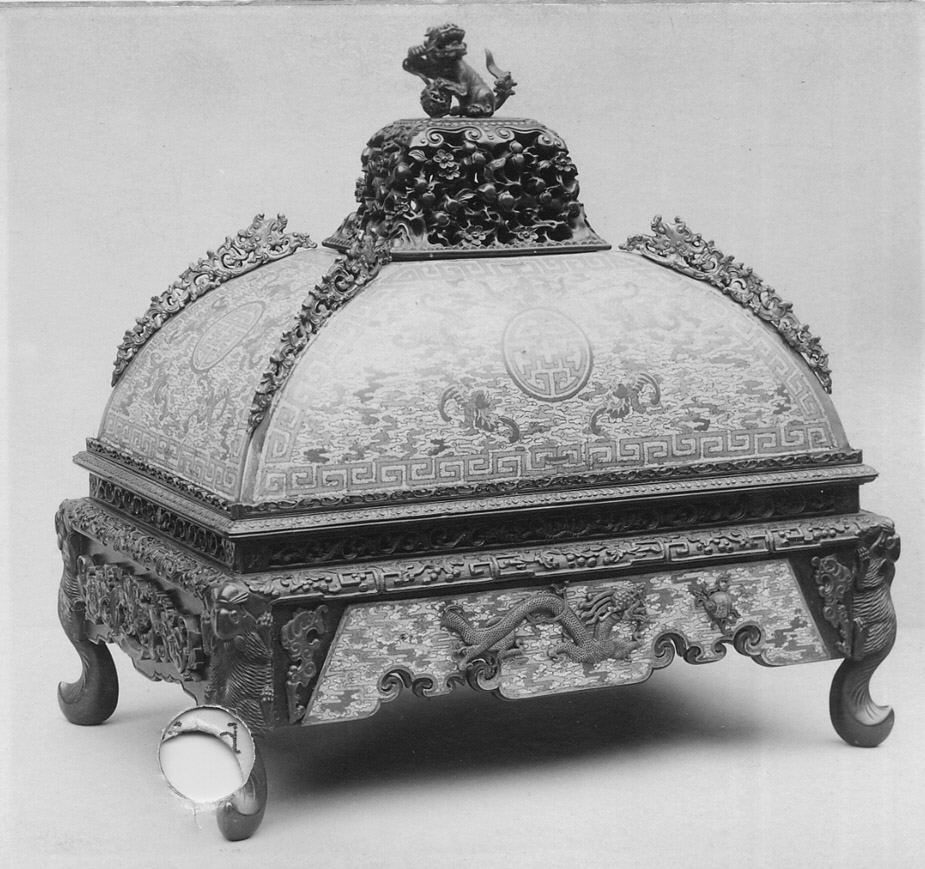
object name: incense burner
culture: chinese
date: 1662-1722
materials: copper, enamel, gilt bronze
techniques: enamel